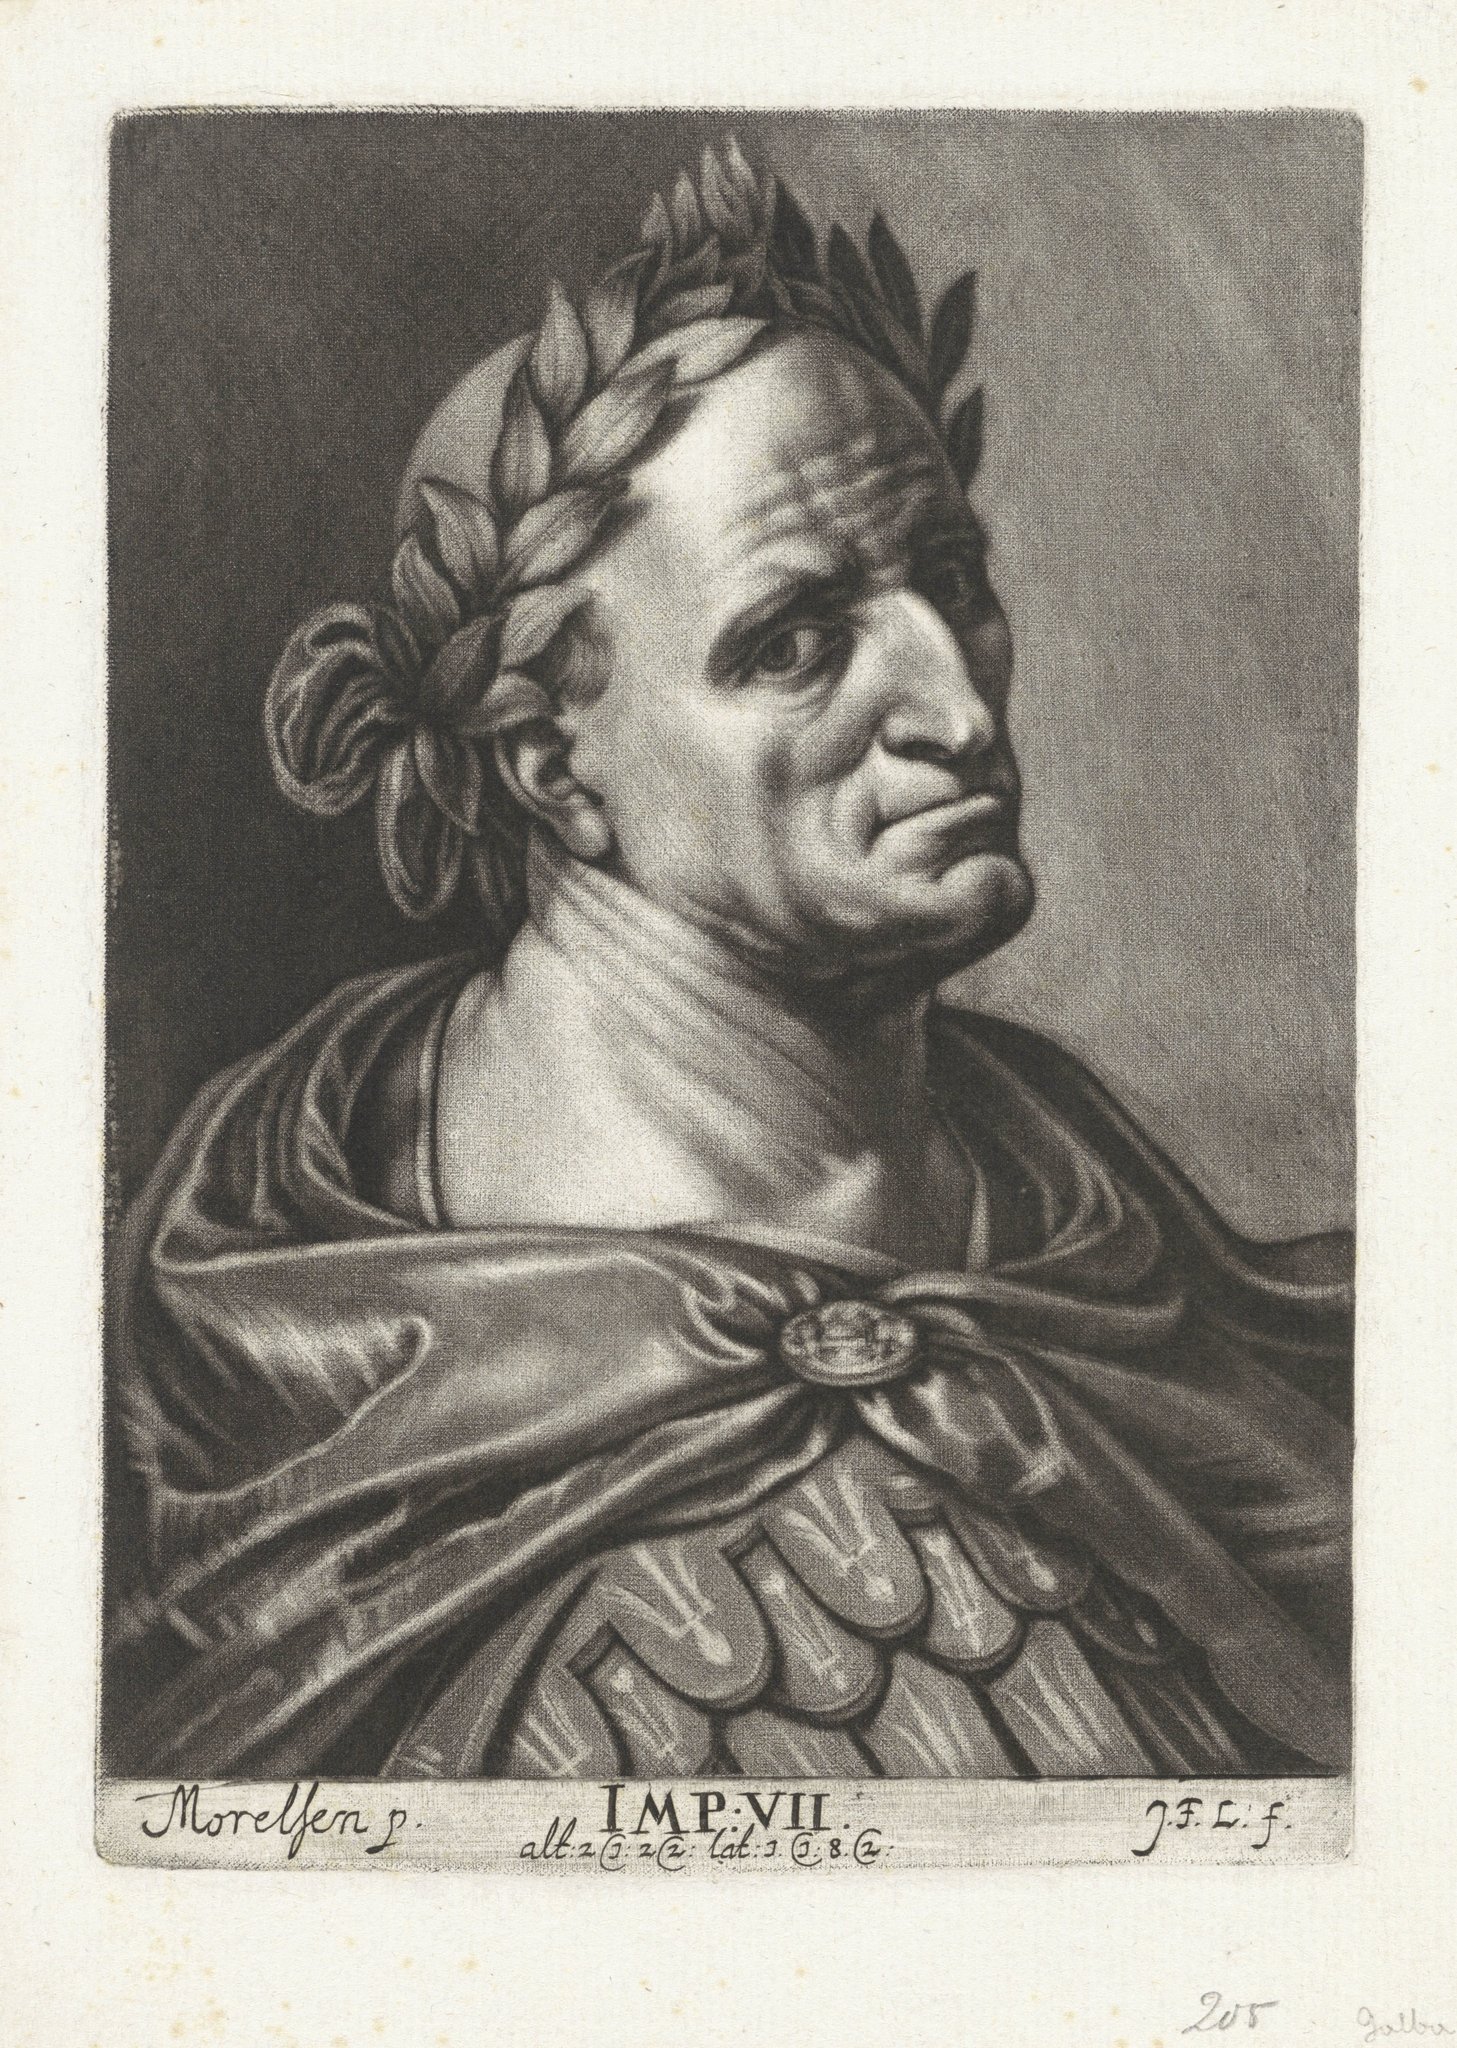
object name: print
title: Portret van keizer Galba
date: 1643-1680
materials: paper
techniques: engraving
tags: keizer, galba (keizer van het romeinse rijk)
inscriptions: collector's mark: Lugt 2166